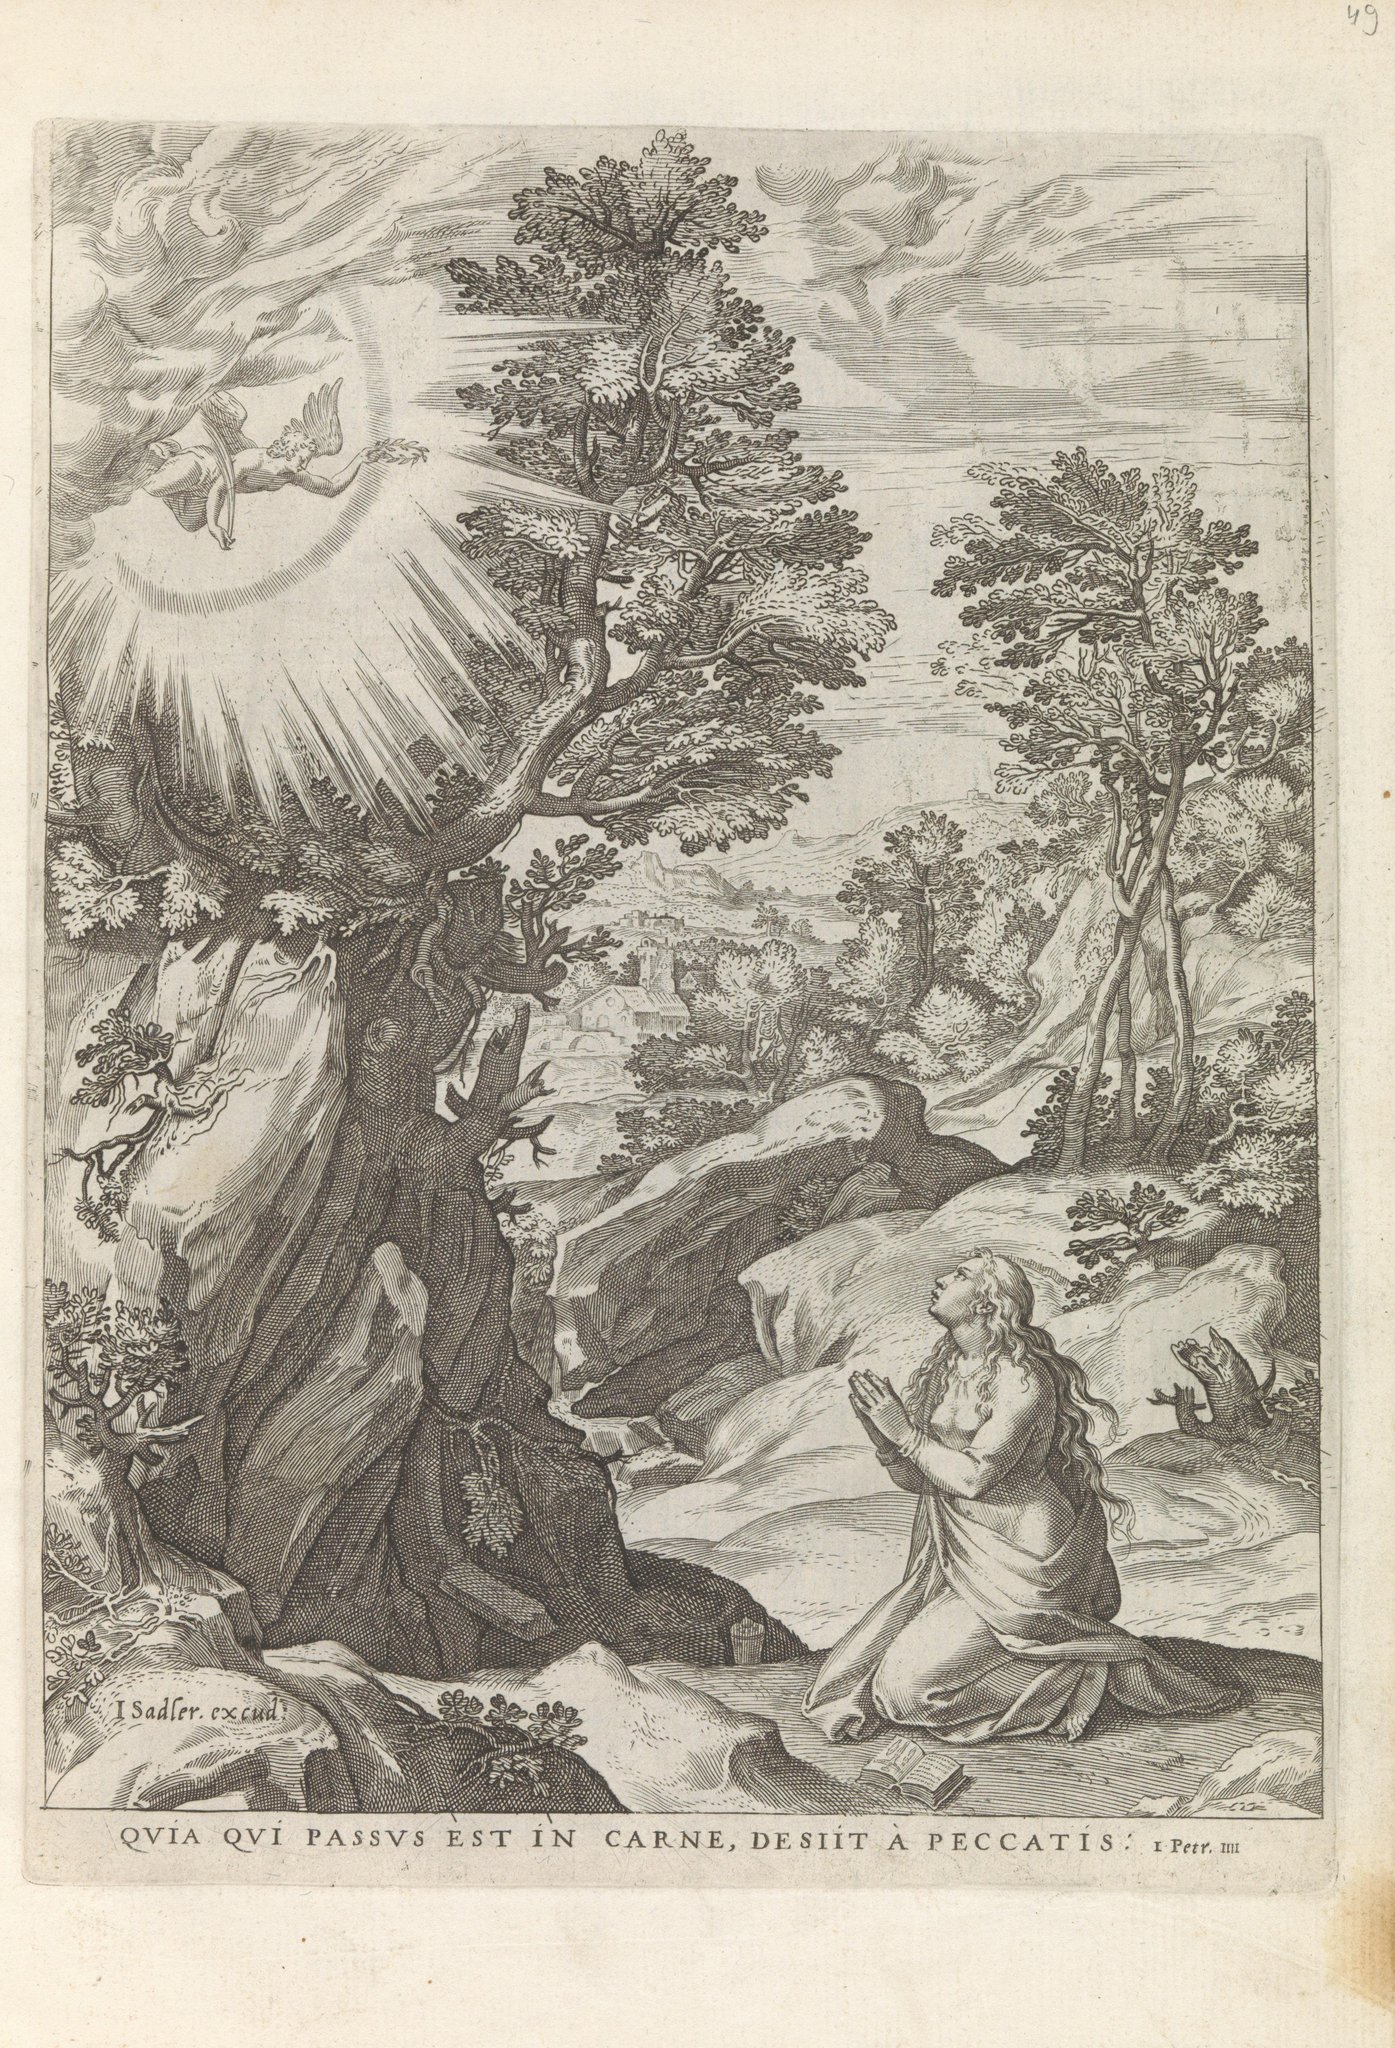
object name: album leaf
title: Landschap met Maria Magdalena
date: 1560-1600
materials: paper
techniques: engraving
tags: the penitent st. mary magdalene (often before a cave, possibly at la sainte-baume hill): her long hair covers her (naked) body, she reads, meditates or raises her tear-filled eyes towards heaven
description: De boetvaardige Maria Magdalena knielt in een landschap bij een grot en kijkt op naar de hemel. Daar ziet ze een engel met een lauwerkrans verschijnen. Onder de voorstelling een verwijzing naar de Bijbeltekst in 1 Petr. 4 in Latijn. Deze prent maakt deel uit van een album.